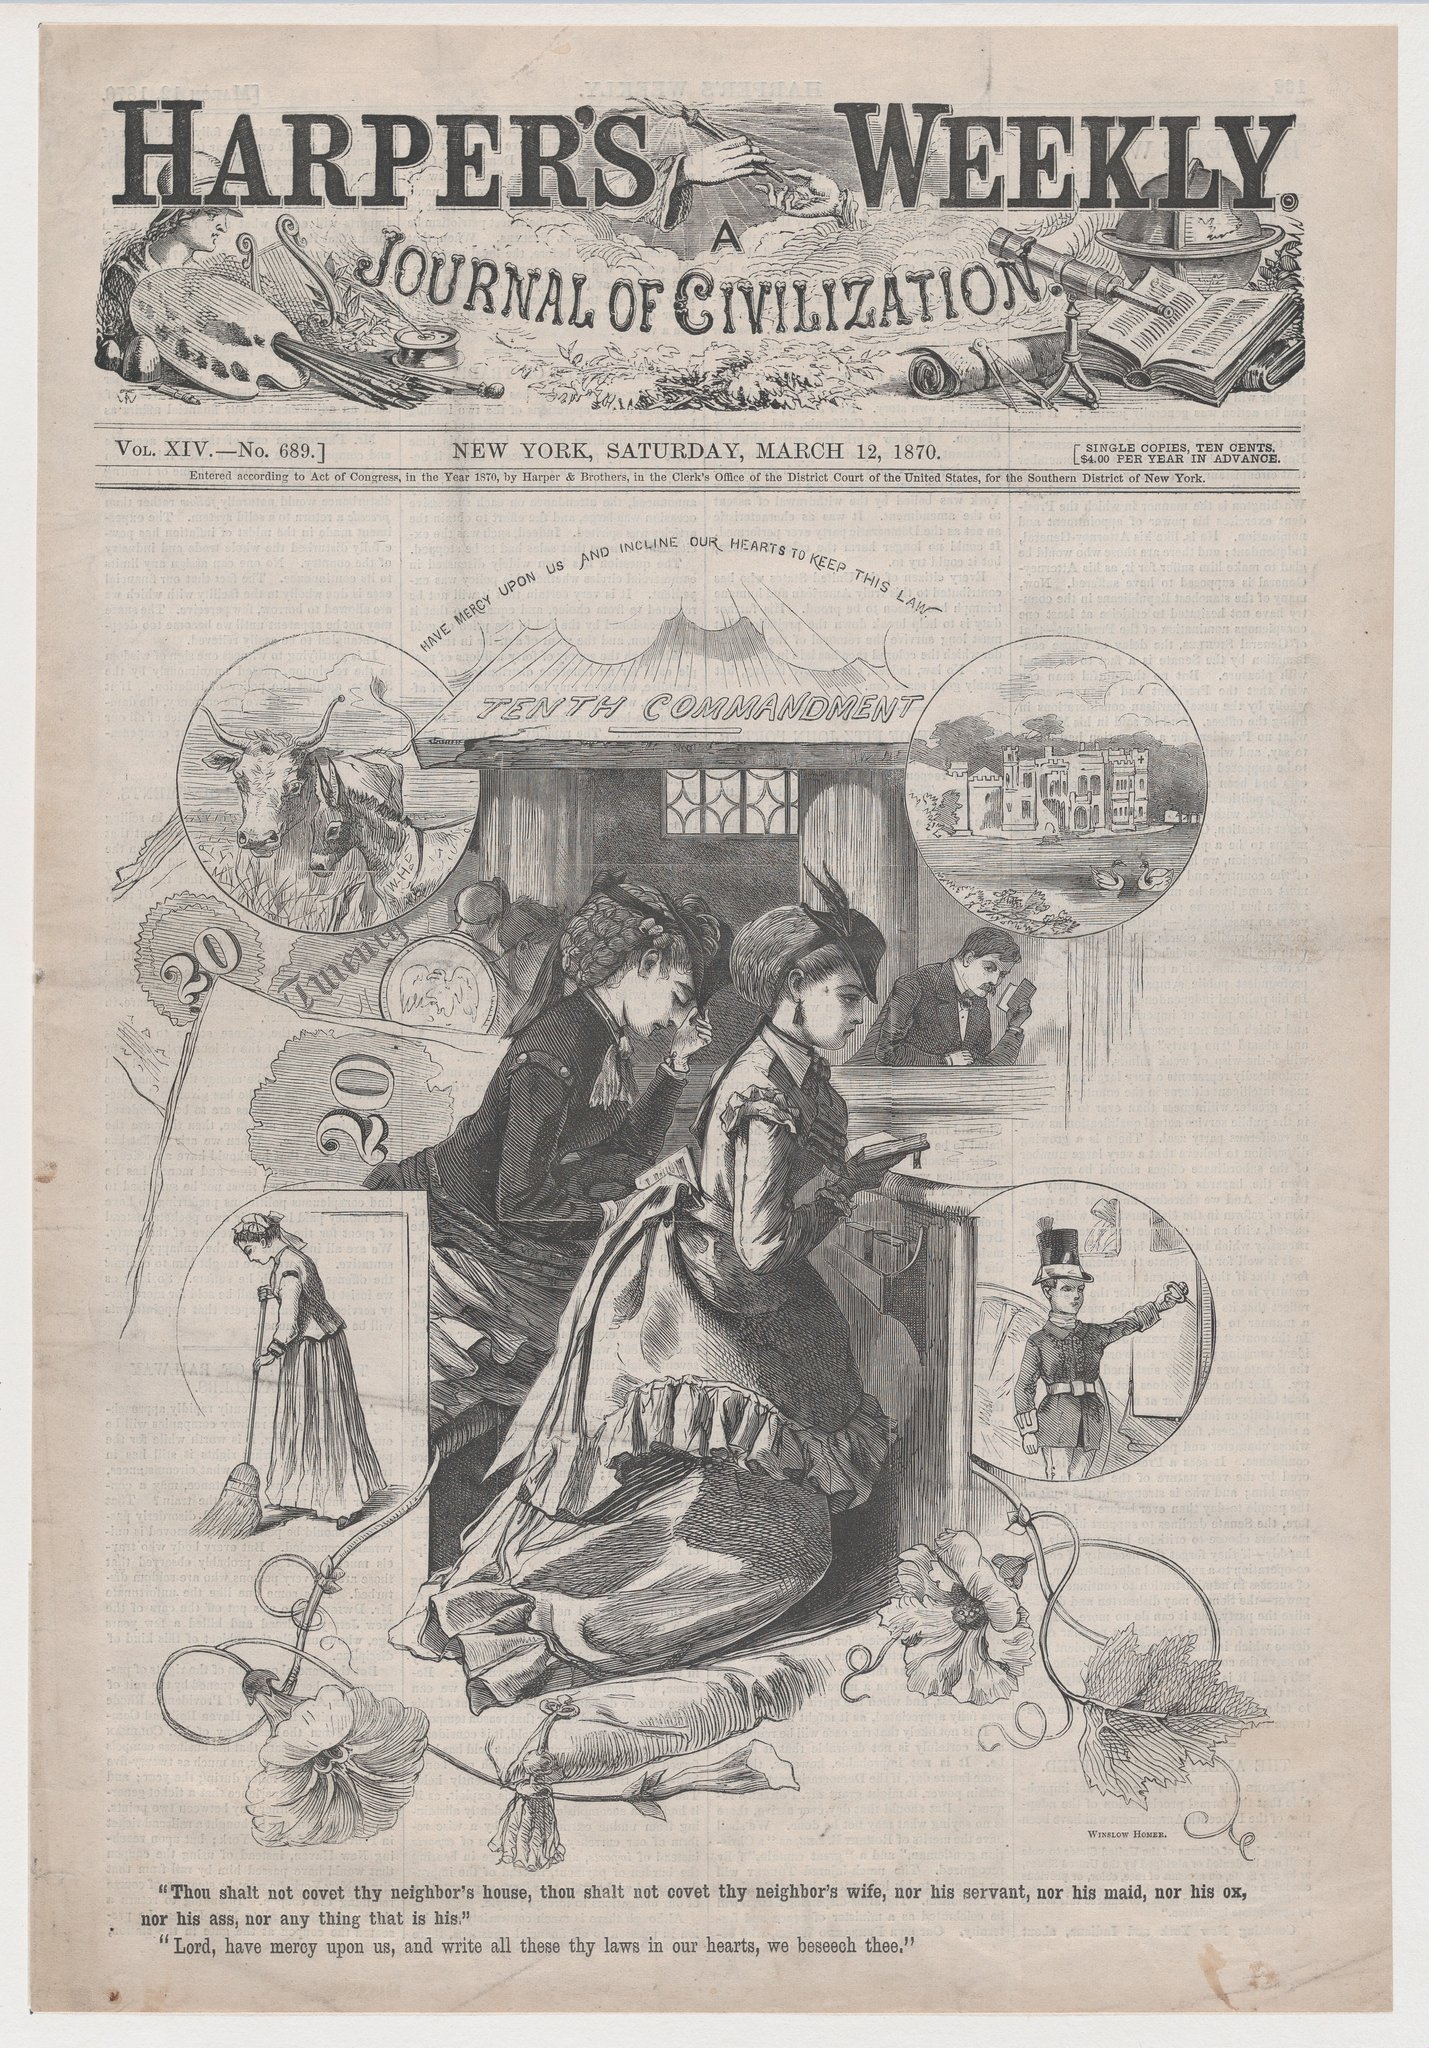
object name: print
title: "Tenth Commandment" (from "Harper's Weekly," Vol. XIV)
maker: winslow homer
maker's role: artist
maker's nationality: american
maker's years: 1836-1910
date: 1870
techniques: engraving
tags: men,women,cows,donkeys